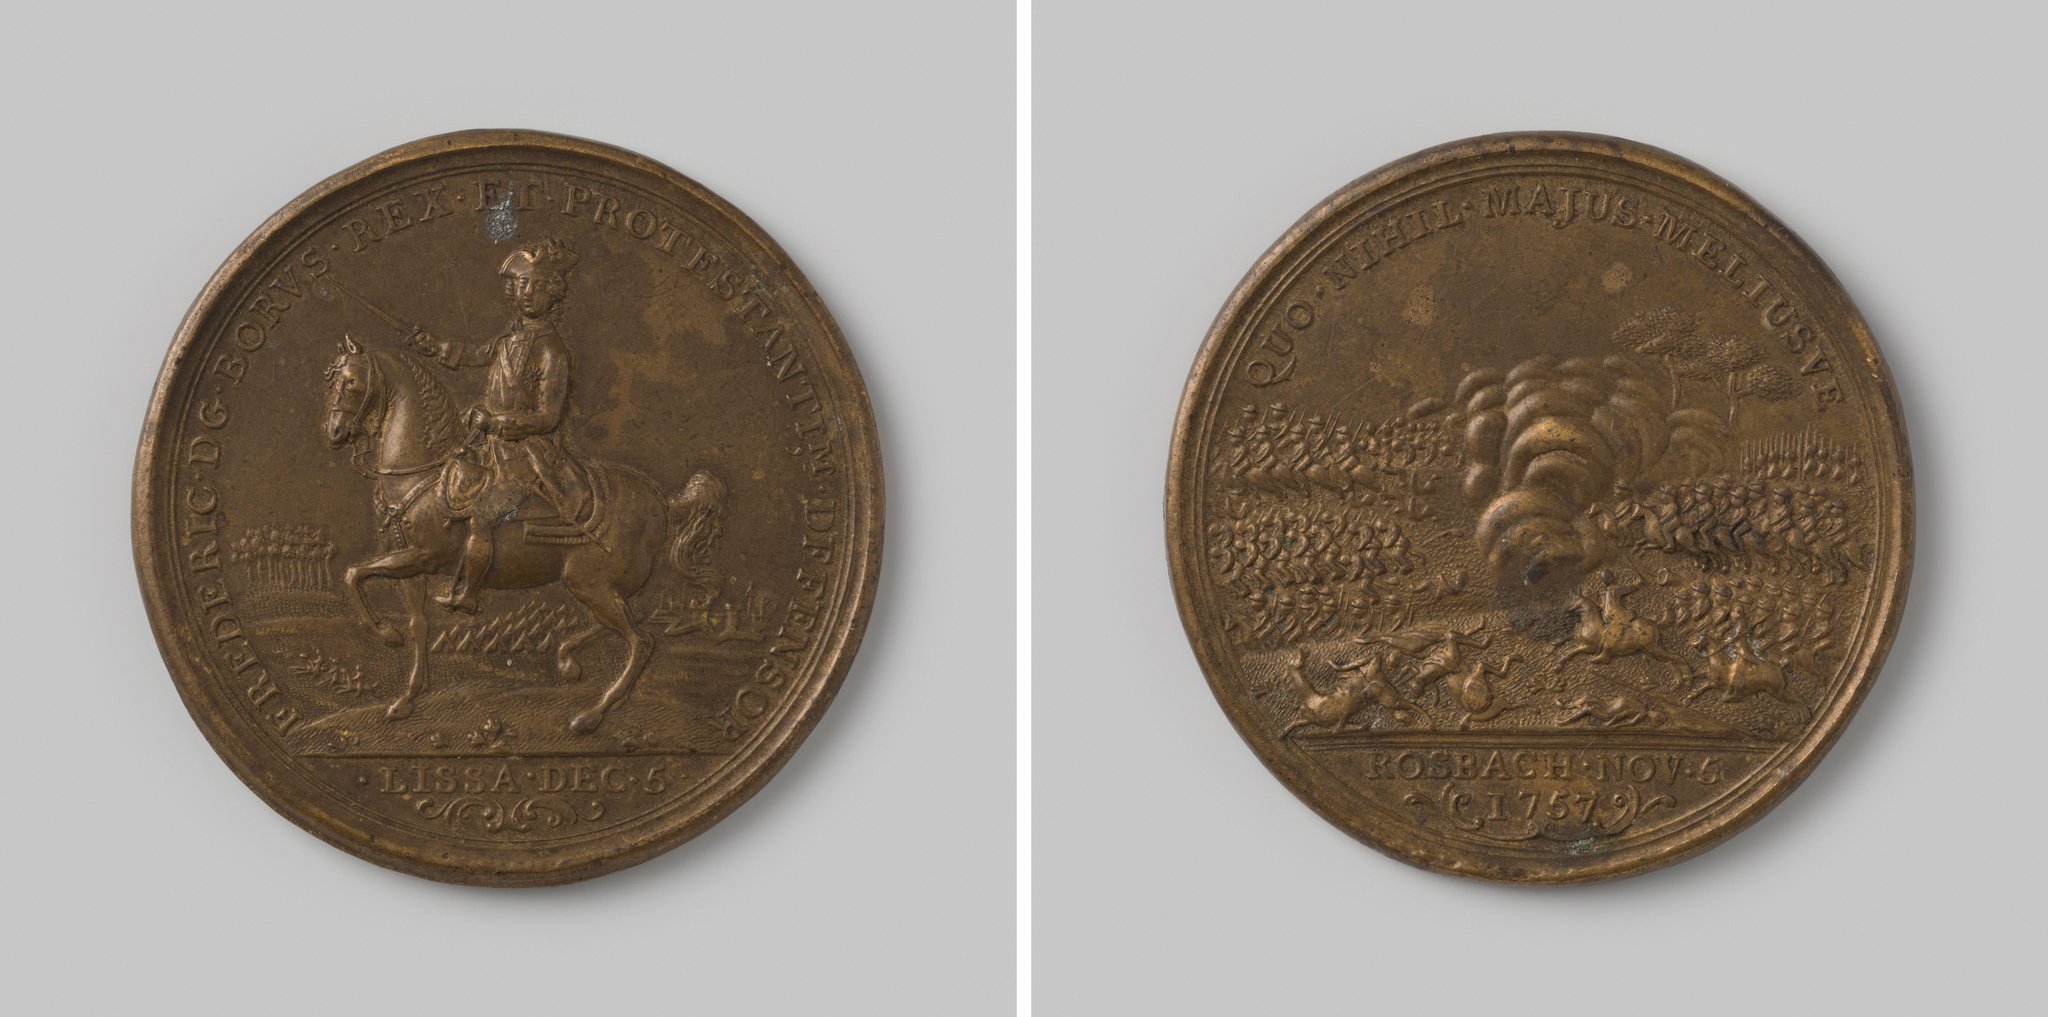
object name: history medal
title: Slag bij Rosbach en Lissa 1757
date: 1757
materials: brass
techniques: striking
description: Messing penning, op de voorzijde Frederik te paard in een landschap met legerkamp, met omschrift, op de keerzijde de veldslag bij Rosbach, met omschrift bovenaan en afsnedetekst.